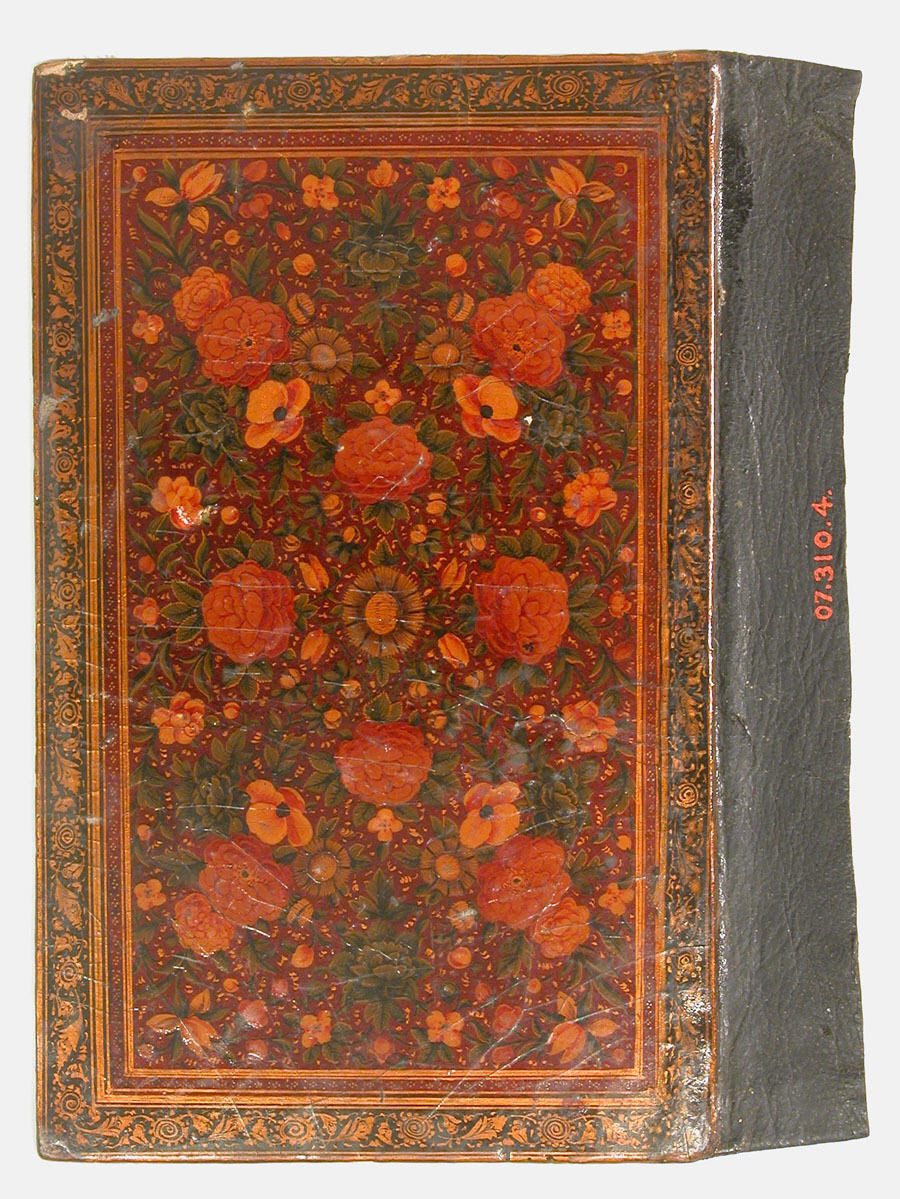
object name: bookbinding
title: Bookbinding (Jild-i kitab)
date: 1801-1900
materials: board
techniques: lacquer, painting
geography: iran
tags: flowers